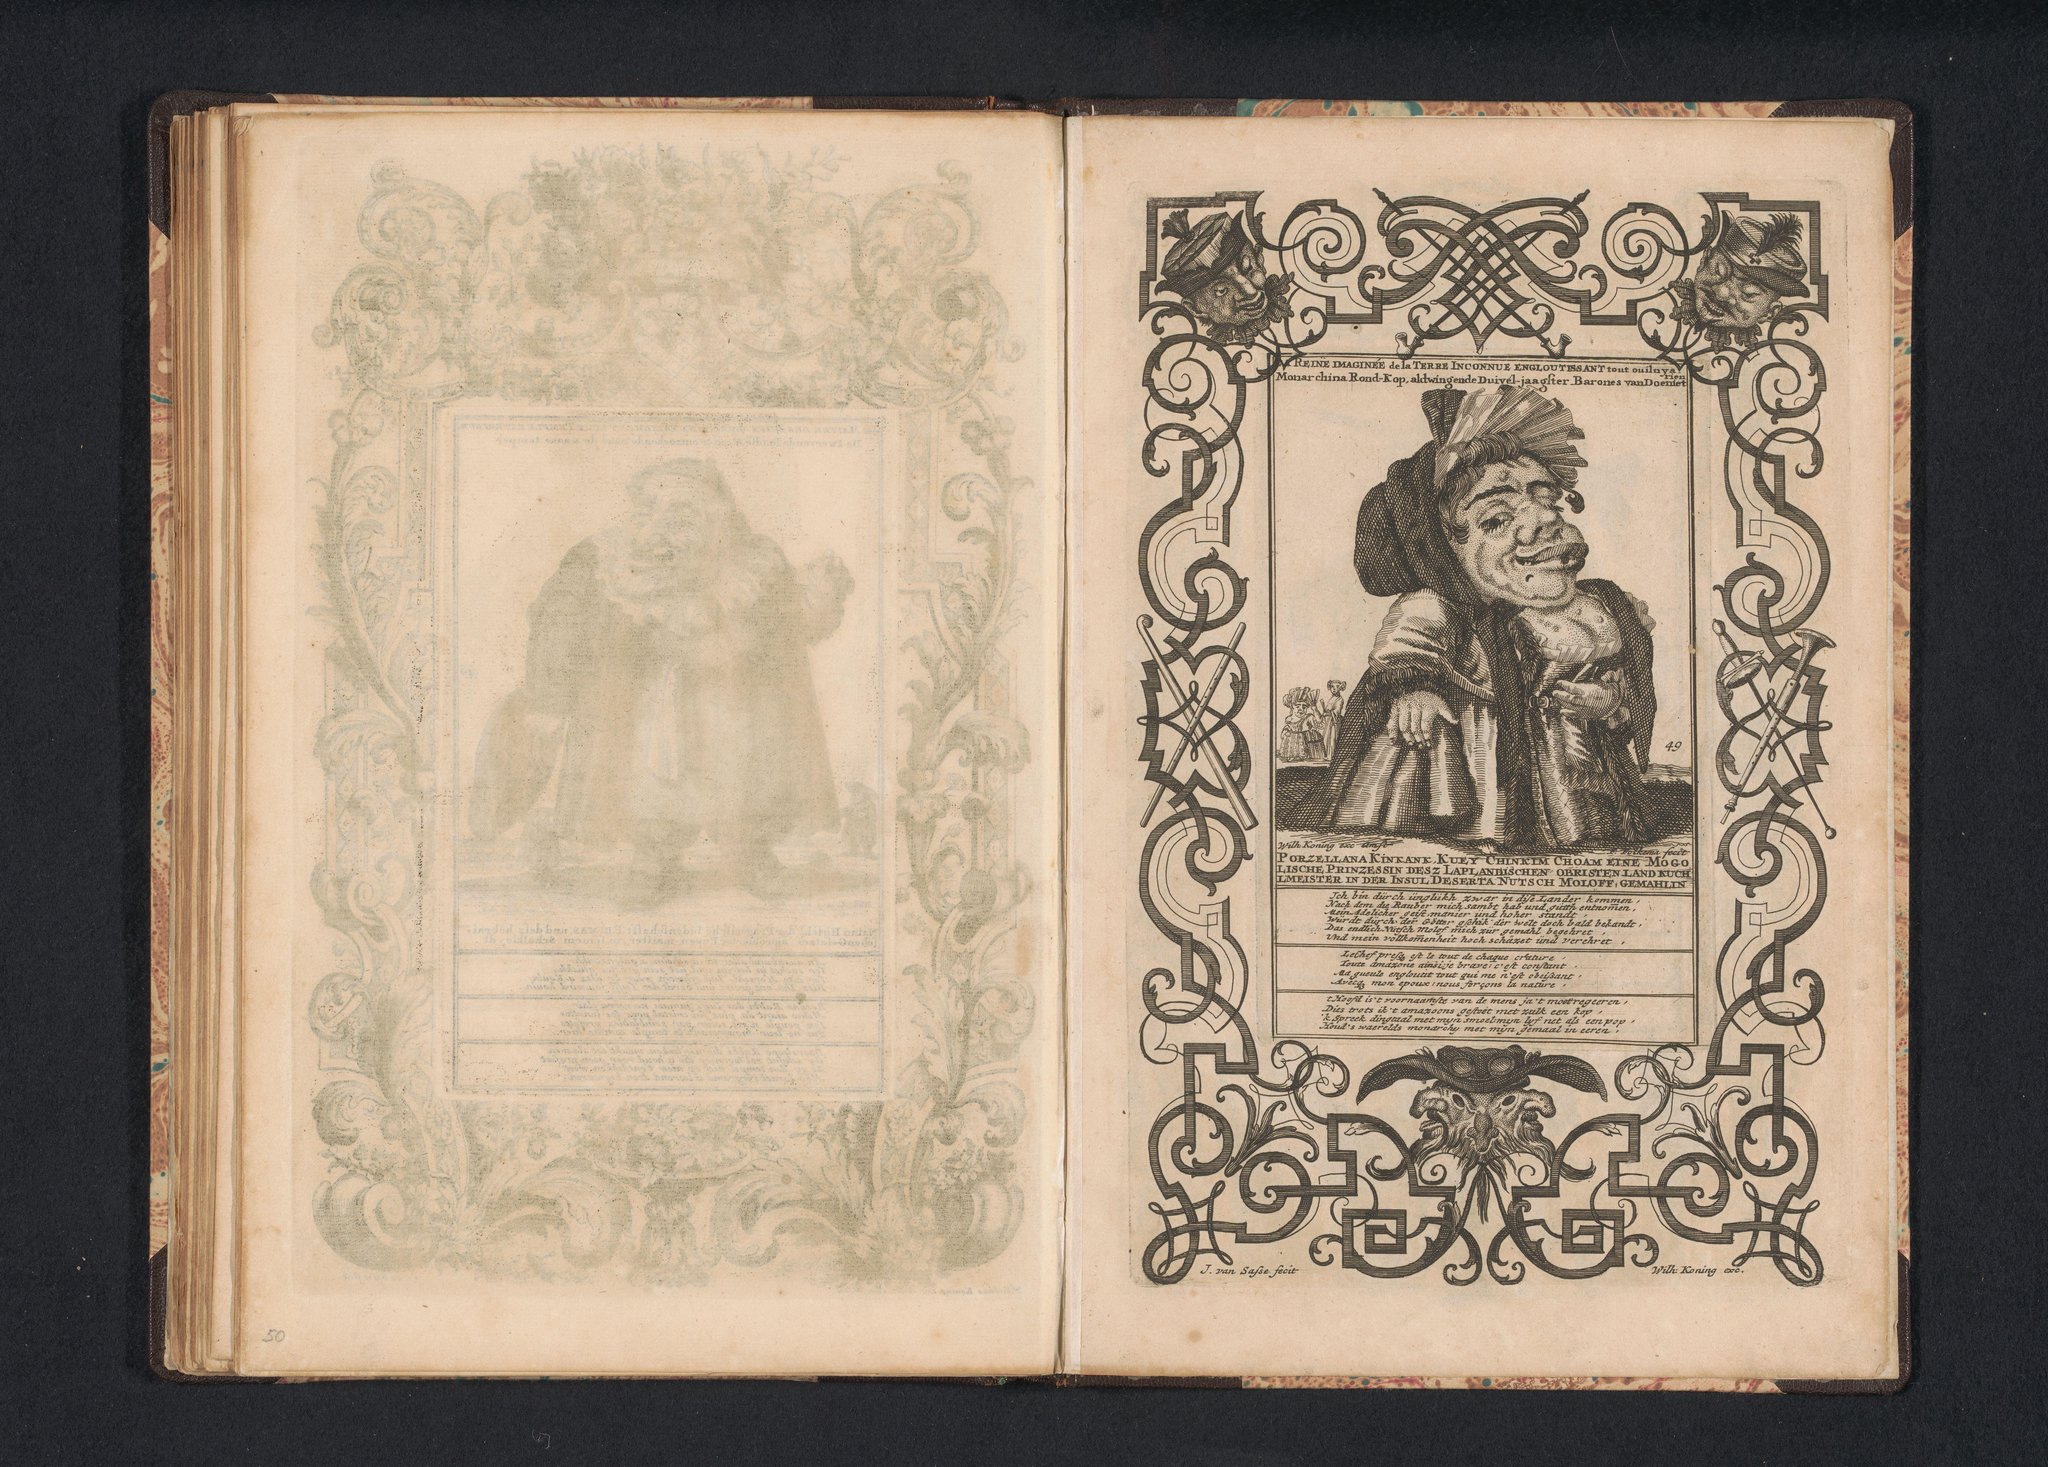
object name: print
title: De kleine mens Monarchina Rond-Kop, 1716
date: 1716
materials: paper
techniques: etching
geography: amsterdam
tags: caricatures (human types), little people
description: De kleine mens Monarchina Rond-Kop, echtgenote van Brutal-tronius van Aldwing-burg. In het onderschrift verzen in het Duits, Frans en Nederlands. Afdruk binnen een decoratieve omlijsting gedrukt van een aparte plaat met koppen van kleine mensen en maskers. Genummerd rechts midden: 49. Onderdeel van de Nederlandse gebonden uitgave uit 1716 van een serie karikaturen van kleine mensen, bekend als Het Dwergentooneel, gekopieerd naar een ouder Duits voorbeeld.